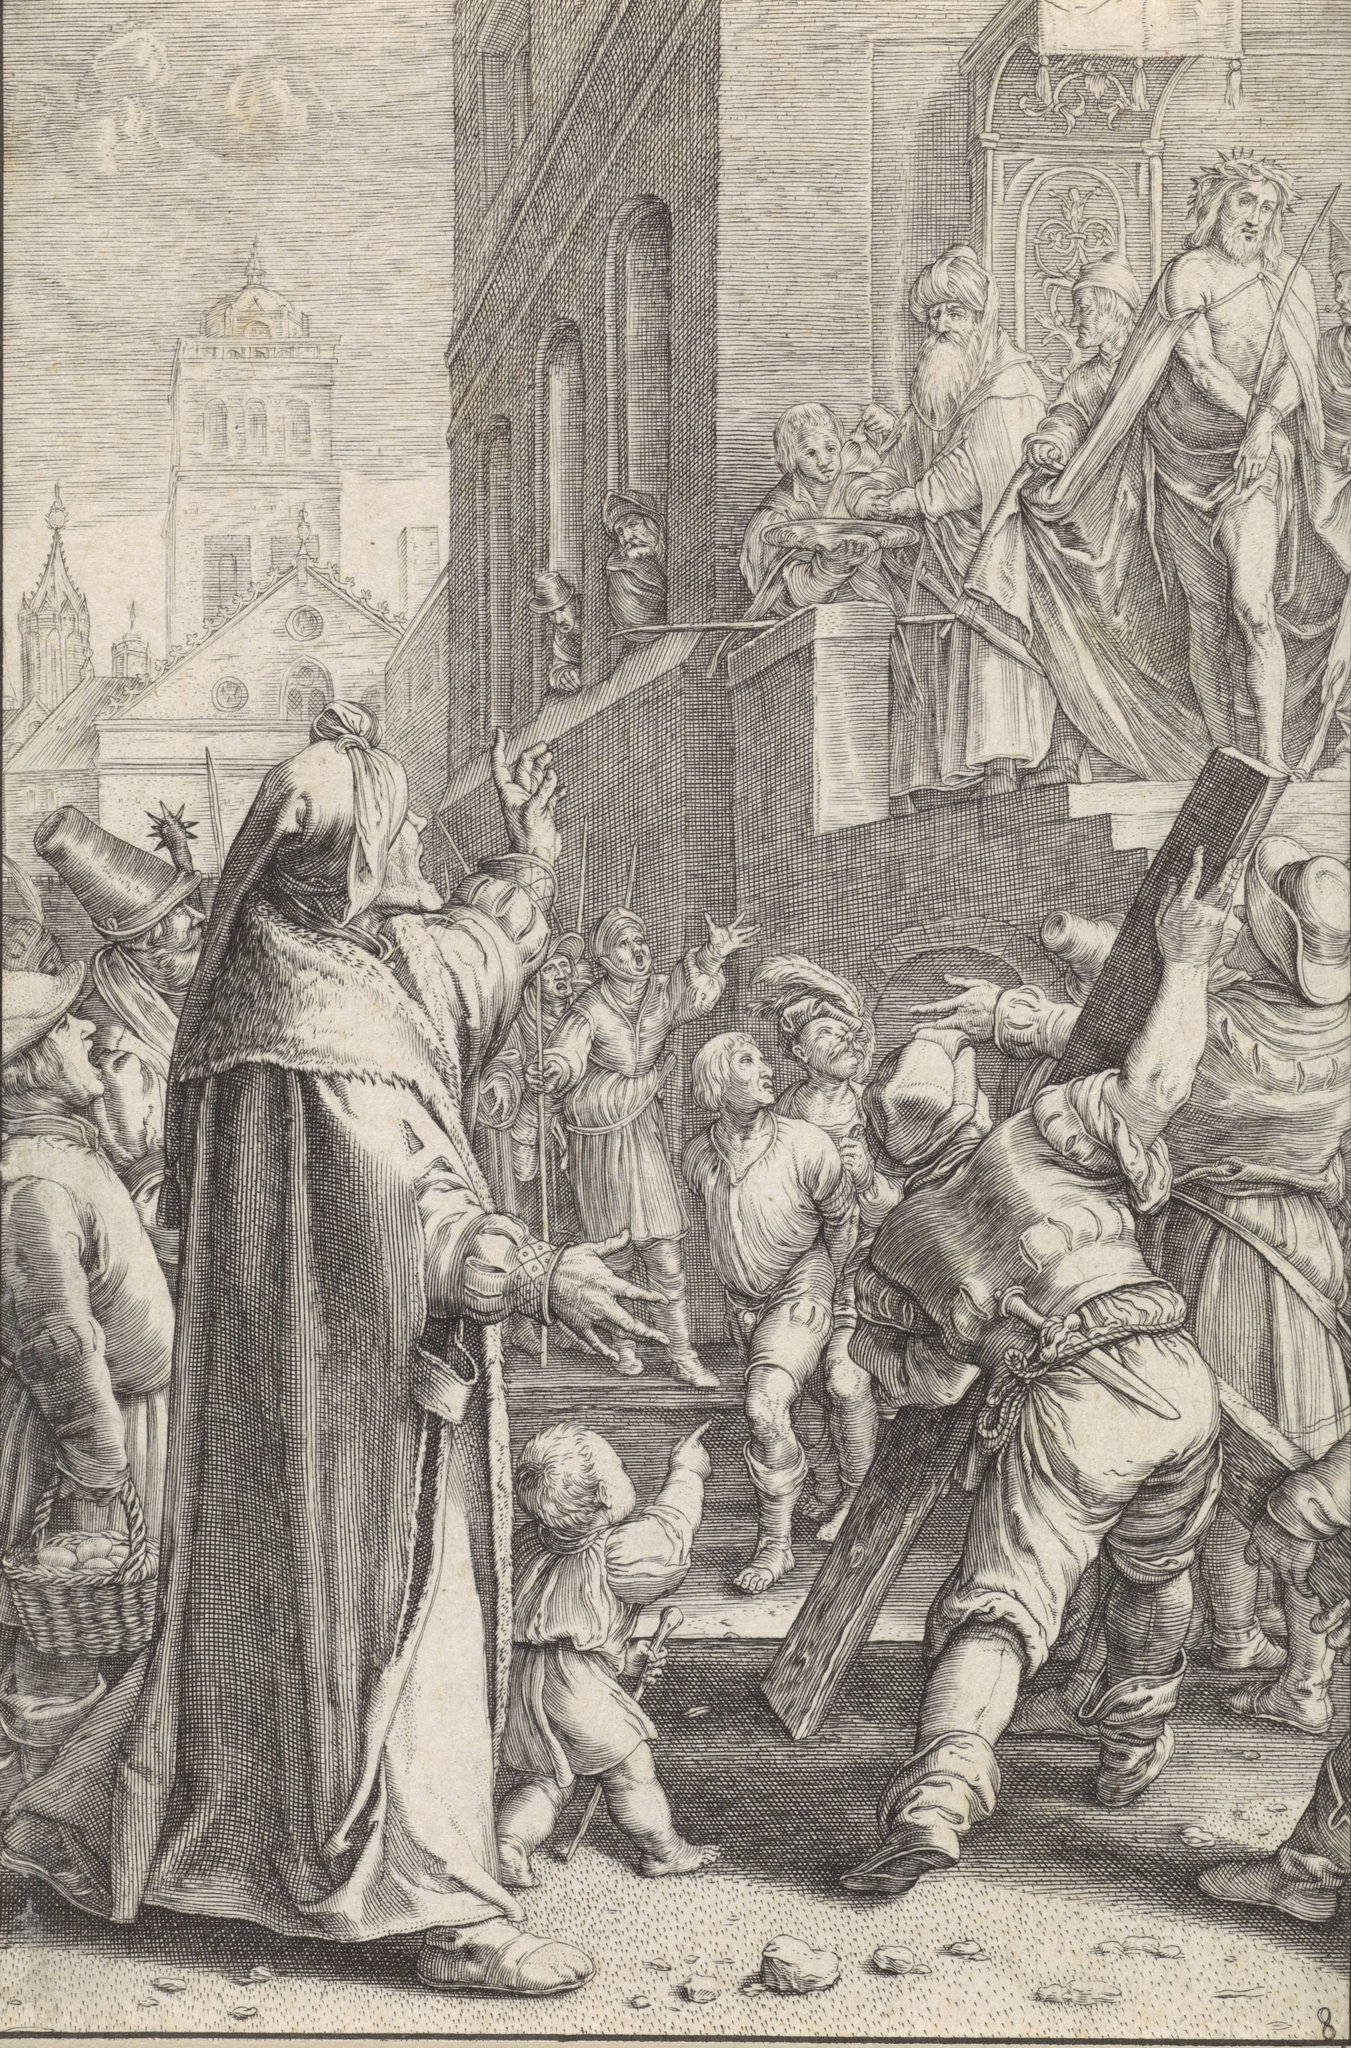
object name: print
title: Christus aan het volk getoond (Ecce homo)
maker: ludovicus siceram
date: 1623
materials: paper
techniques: engraving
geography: antwerp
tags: pilate washing his hands (in innocence), pilate showing christ to the people, 'ostentatio christi', 'ecce homo' (john 19:4-6)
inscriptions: collector's mark: Lugt 2228a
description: Christus wordt door Pilatus op een podium aan het volk getoond. Pilatus heeft aan het volk gevraagd of hij Christus of Barabbas zal vrij laten. Het volk roept dat Barabbas moet worden vrijgelaten, wat in het midden gebeurt, en dat Christus moet worden gekruisigd. Pilatus wast zijn handen in onschuld.